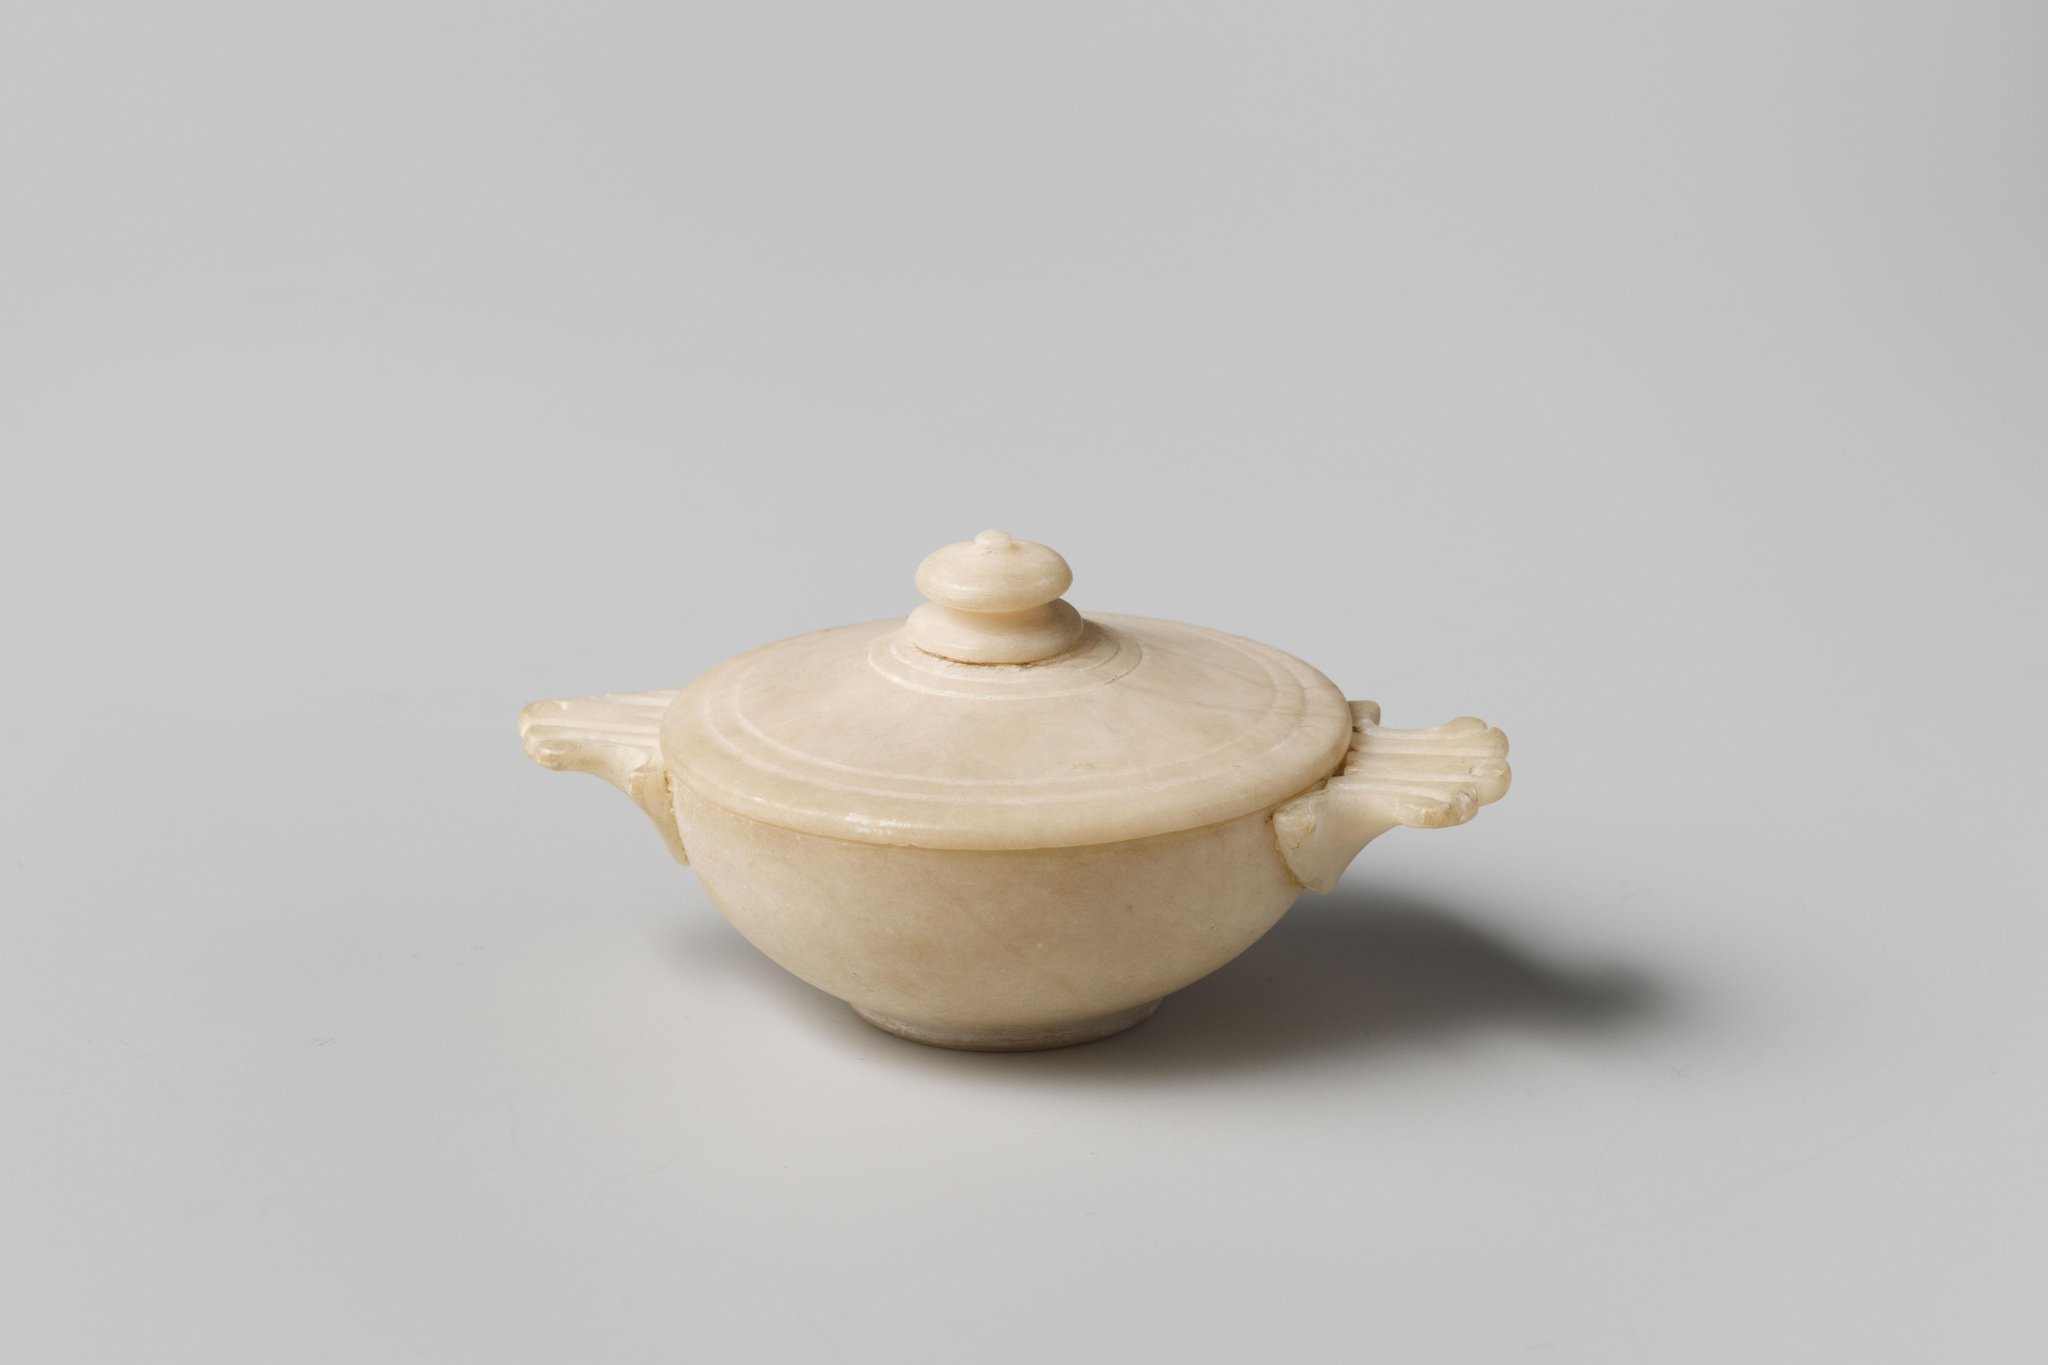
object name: service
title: Papkom met deksel van albast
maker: Anonymous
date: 1650-1699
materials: alabaster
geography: netherlands